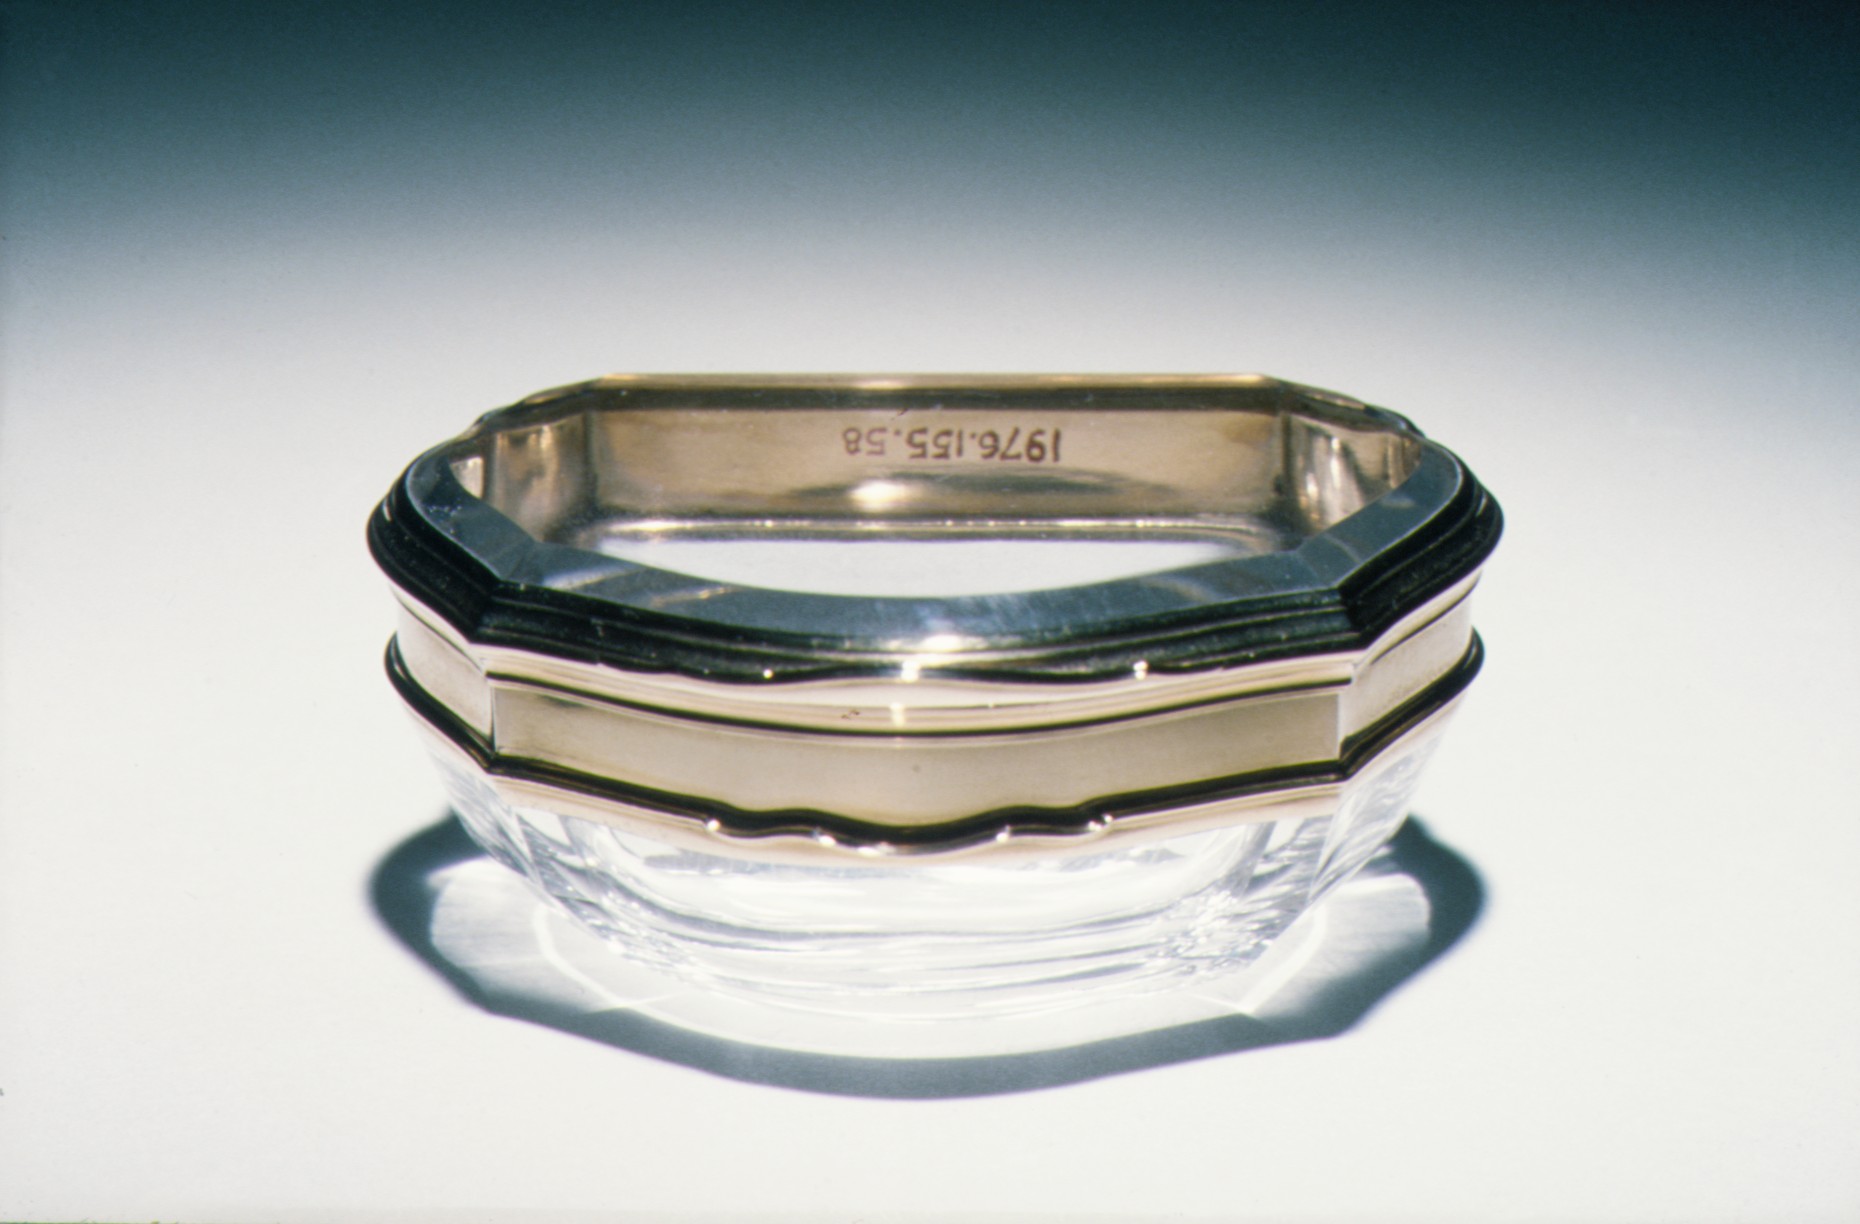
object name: snuffbox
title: Snuffbox (part of a set)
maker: noël hardivillers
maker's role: maker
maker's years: 1679-1779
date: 1728-1730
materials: gold, quartz